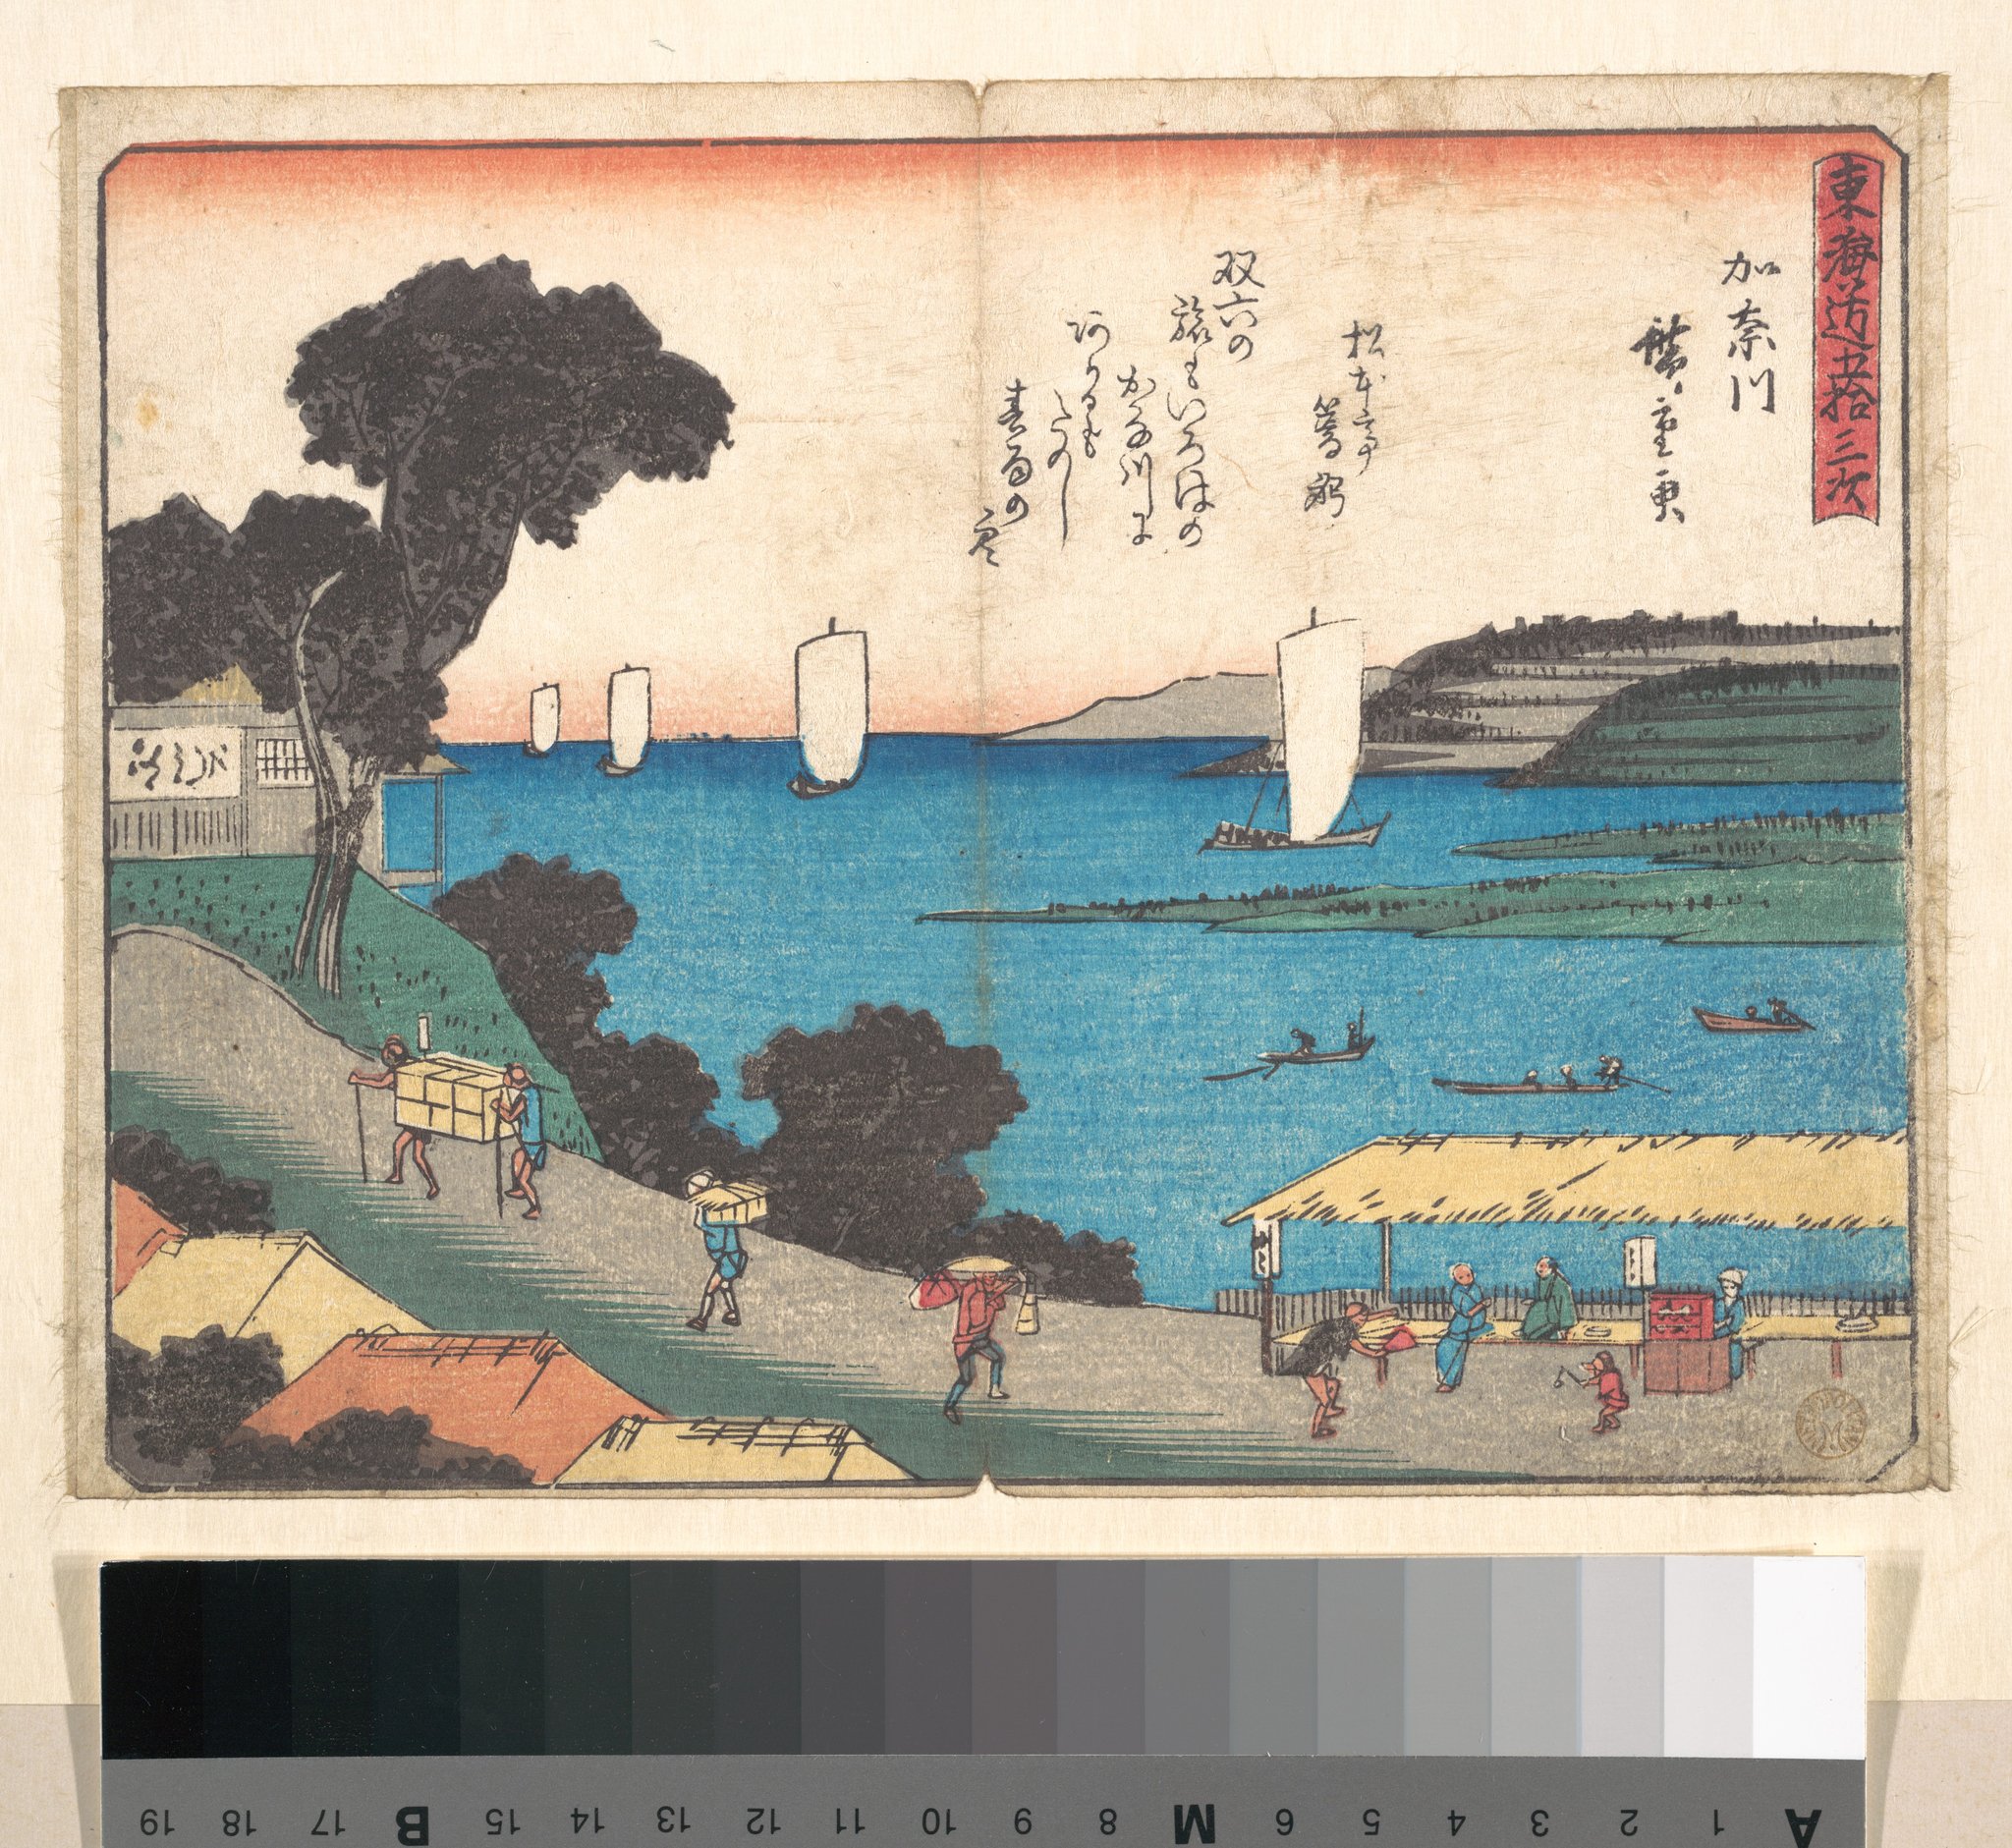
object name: print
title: Kanagawa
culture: japanese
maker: utagawa hiroshige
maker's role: artist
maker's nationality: japanese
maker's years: 1797-1858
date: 1838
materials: ink, paper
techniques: woodblock print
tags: roads,boats